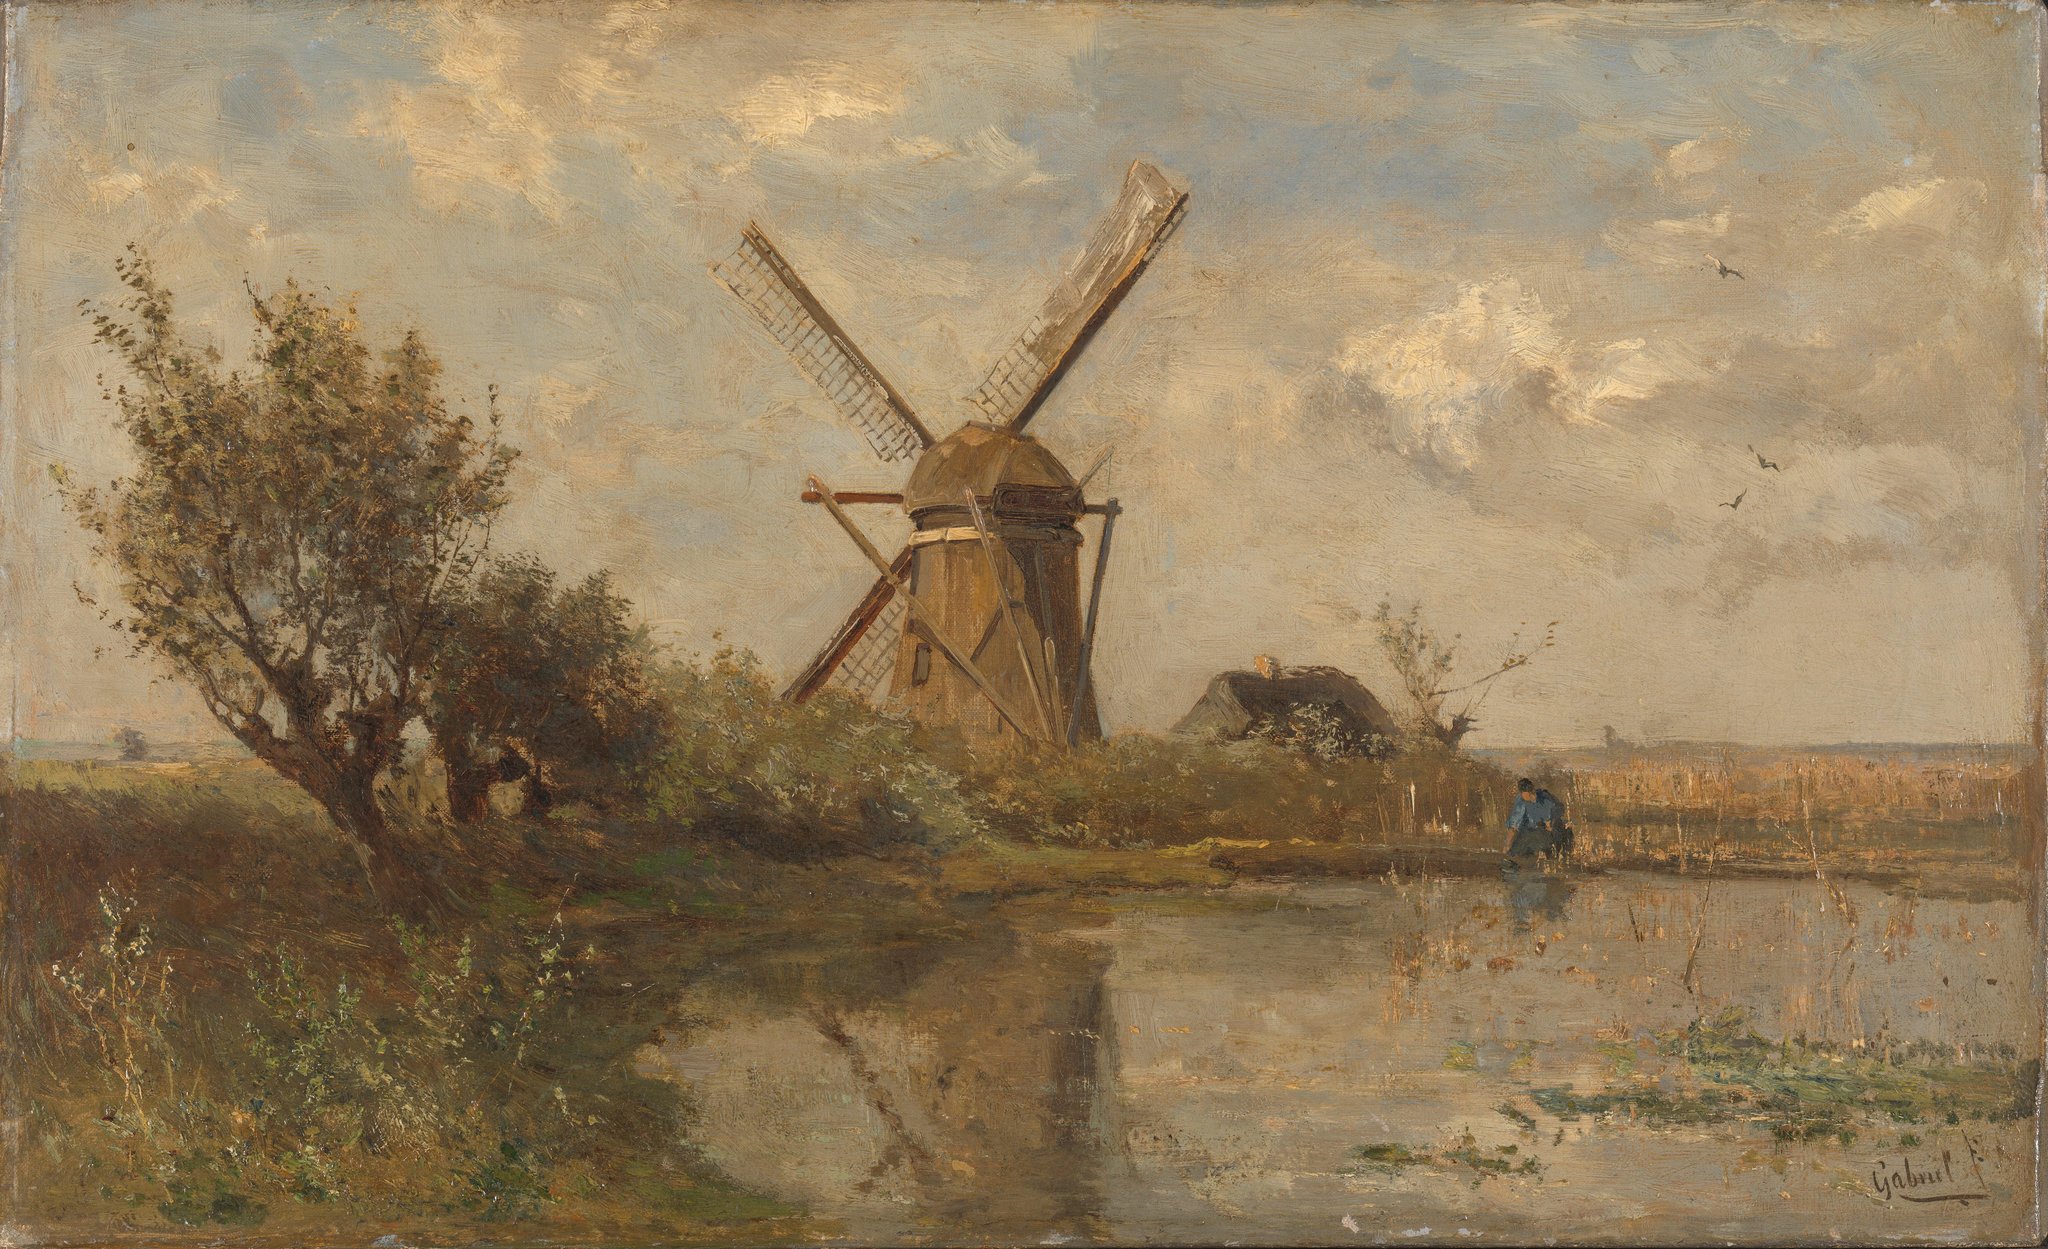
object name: painting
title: Windmill on a Pond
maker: paul joseph constantin gabriël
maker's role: draughtsman, print maker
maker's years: 1828-1903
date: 1860-1903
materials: canvas, oil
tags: windmill in landscape, windmill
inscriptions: signature: ‘Gabriel f:’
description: Landschap met een molen bij een plas. Links een rijtje knotwilgen, aan de overzijde van het water knielt een persoon.